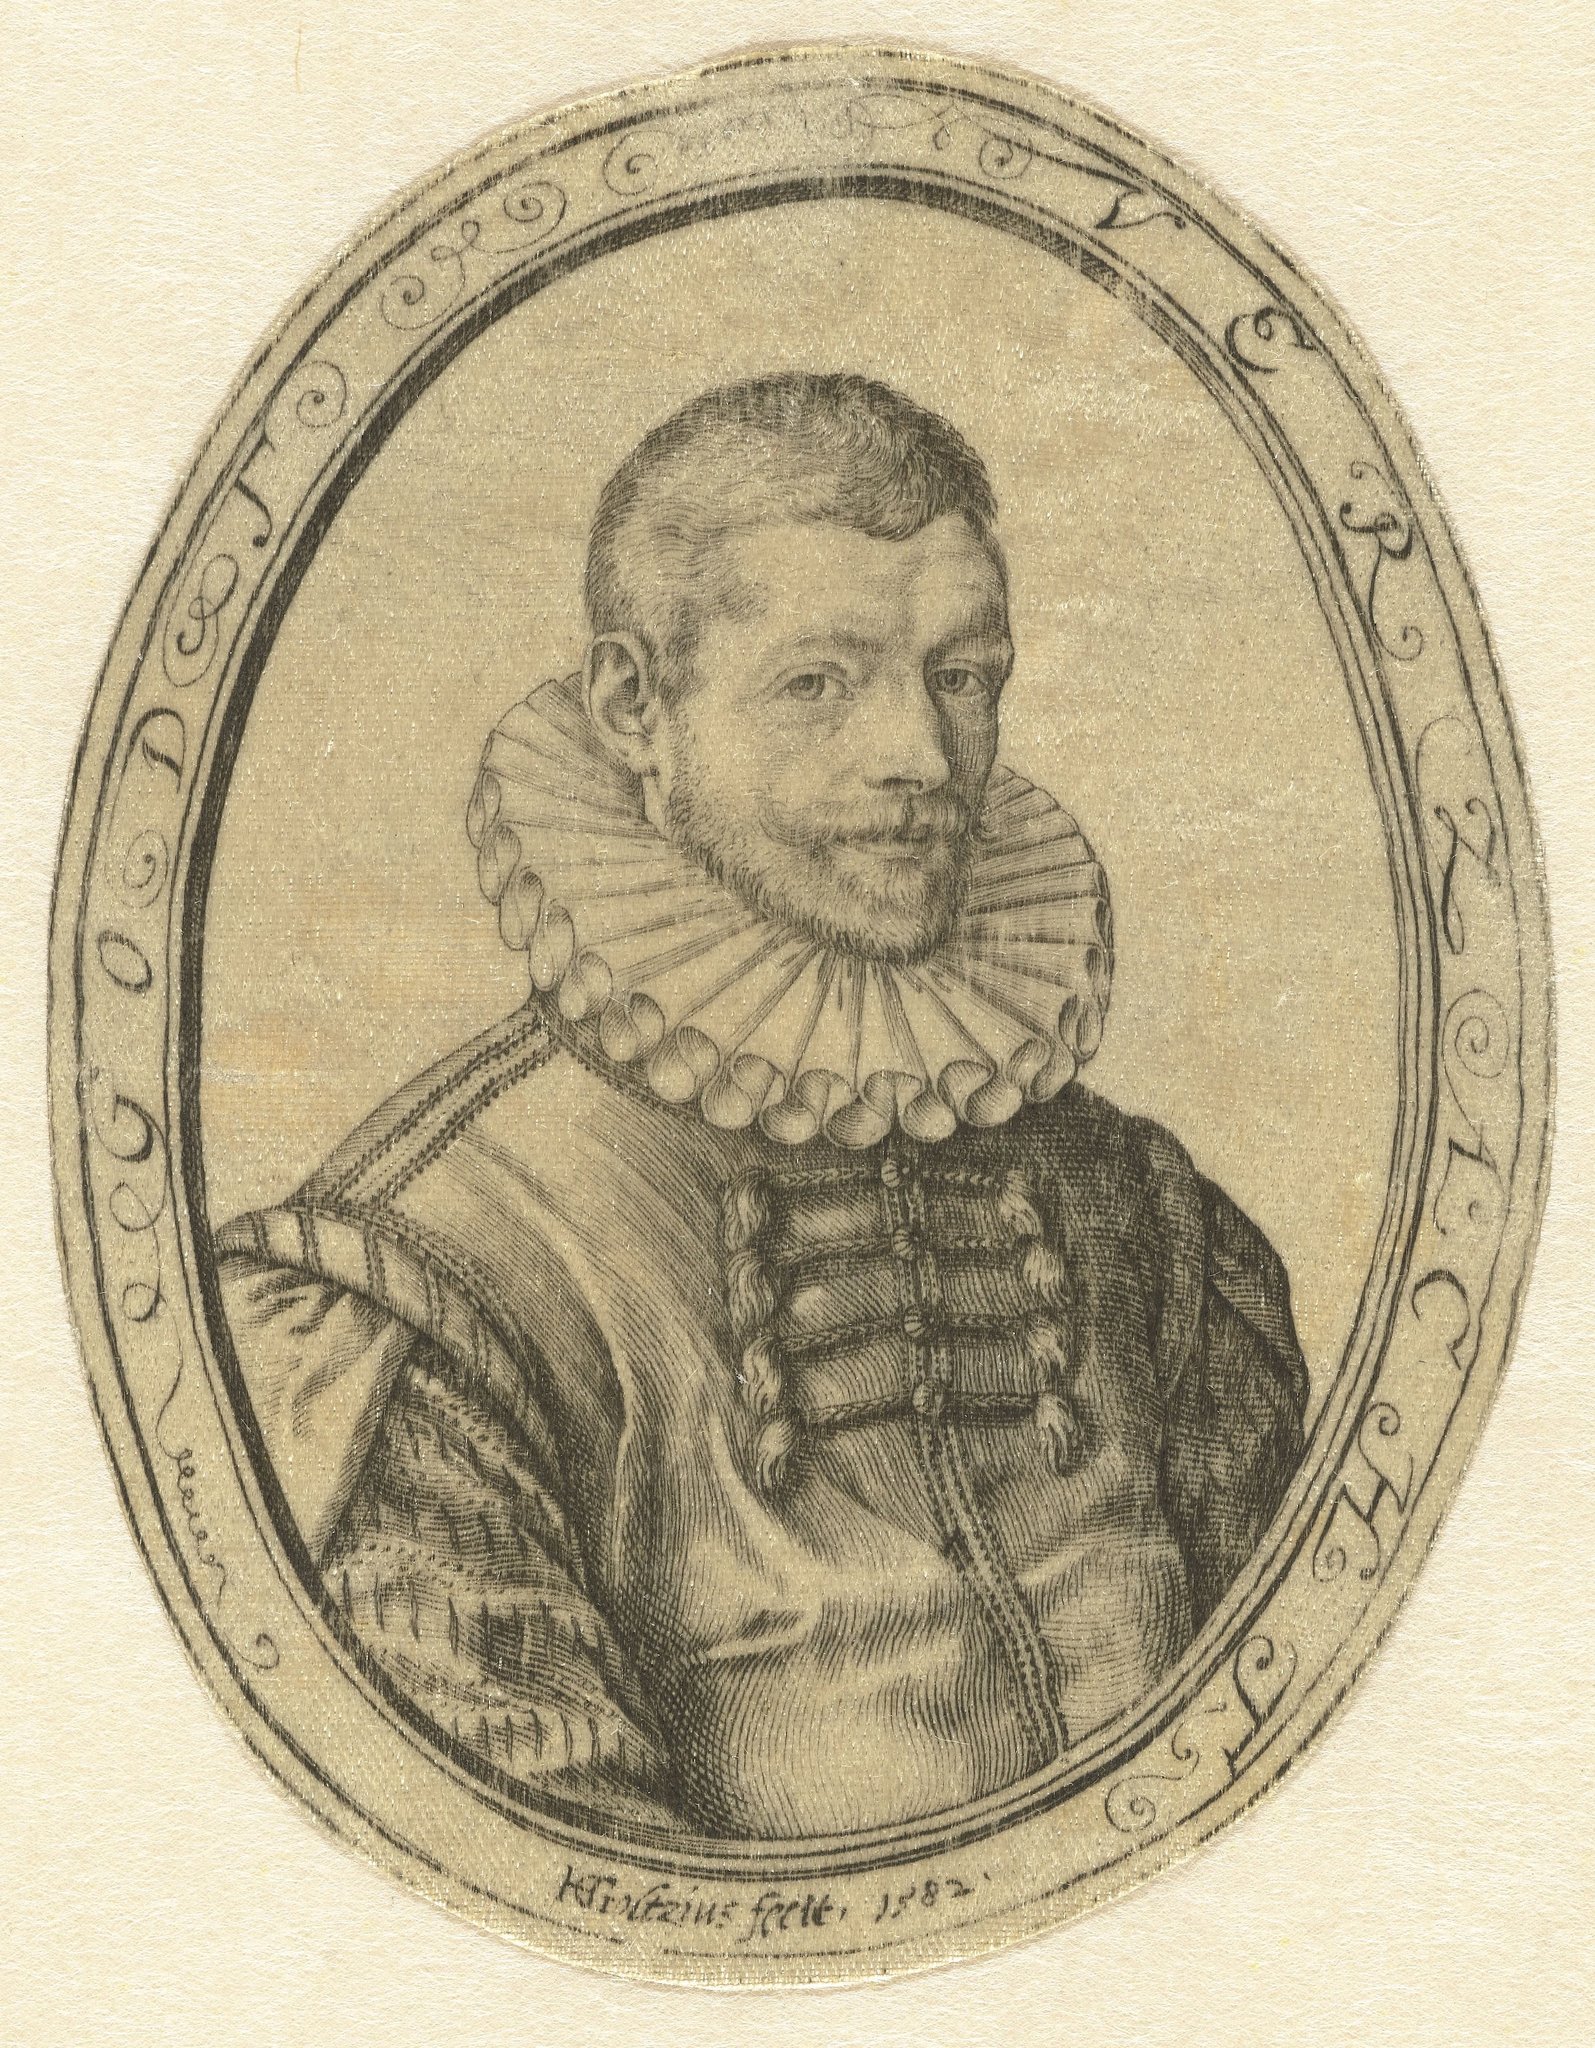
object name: print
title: Godt verzacht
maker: hendrick goltzius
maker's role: draughtsman, painter, print maker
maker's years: 1558-1617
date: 1582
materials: textile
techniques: engraving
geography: haarlem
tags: neck-gear ~ clothing (with name), historical persons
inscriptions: signature and date: ‘HGoltzius fecit. 1582’, collector's mark: Lugt 240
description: Portret van een man met grote plooikraag, ten halven lijve. Niet geheel duidelijk wie hier is afgebeeld: Hans Felbbier of Jacob Gyscher. Randinscriptie rondom het ovaal.